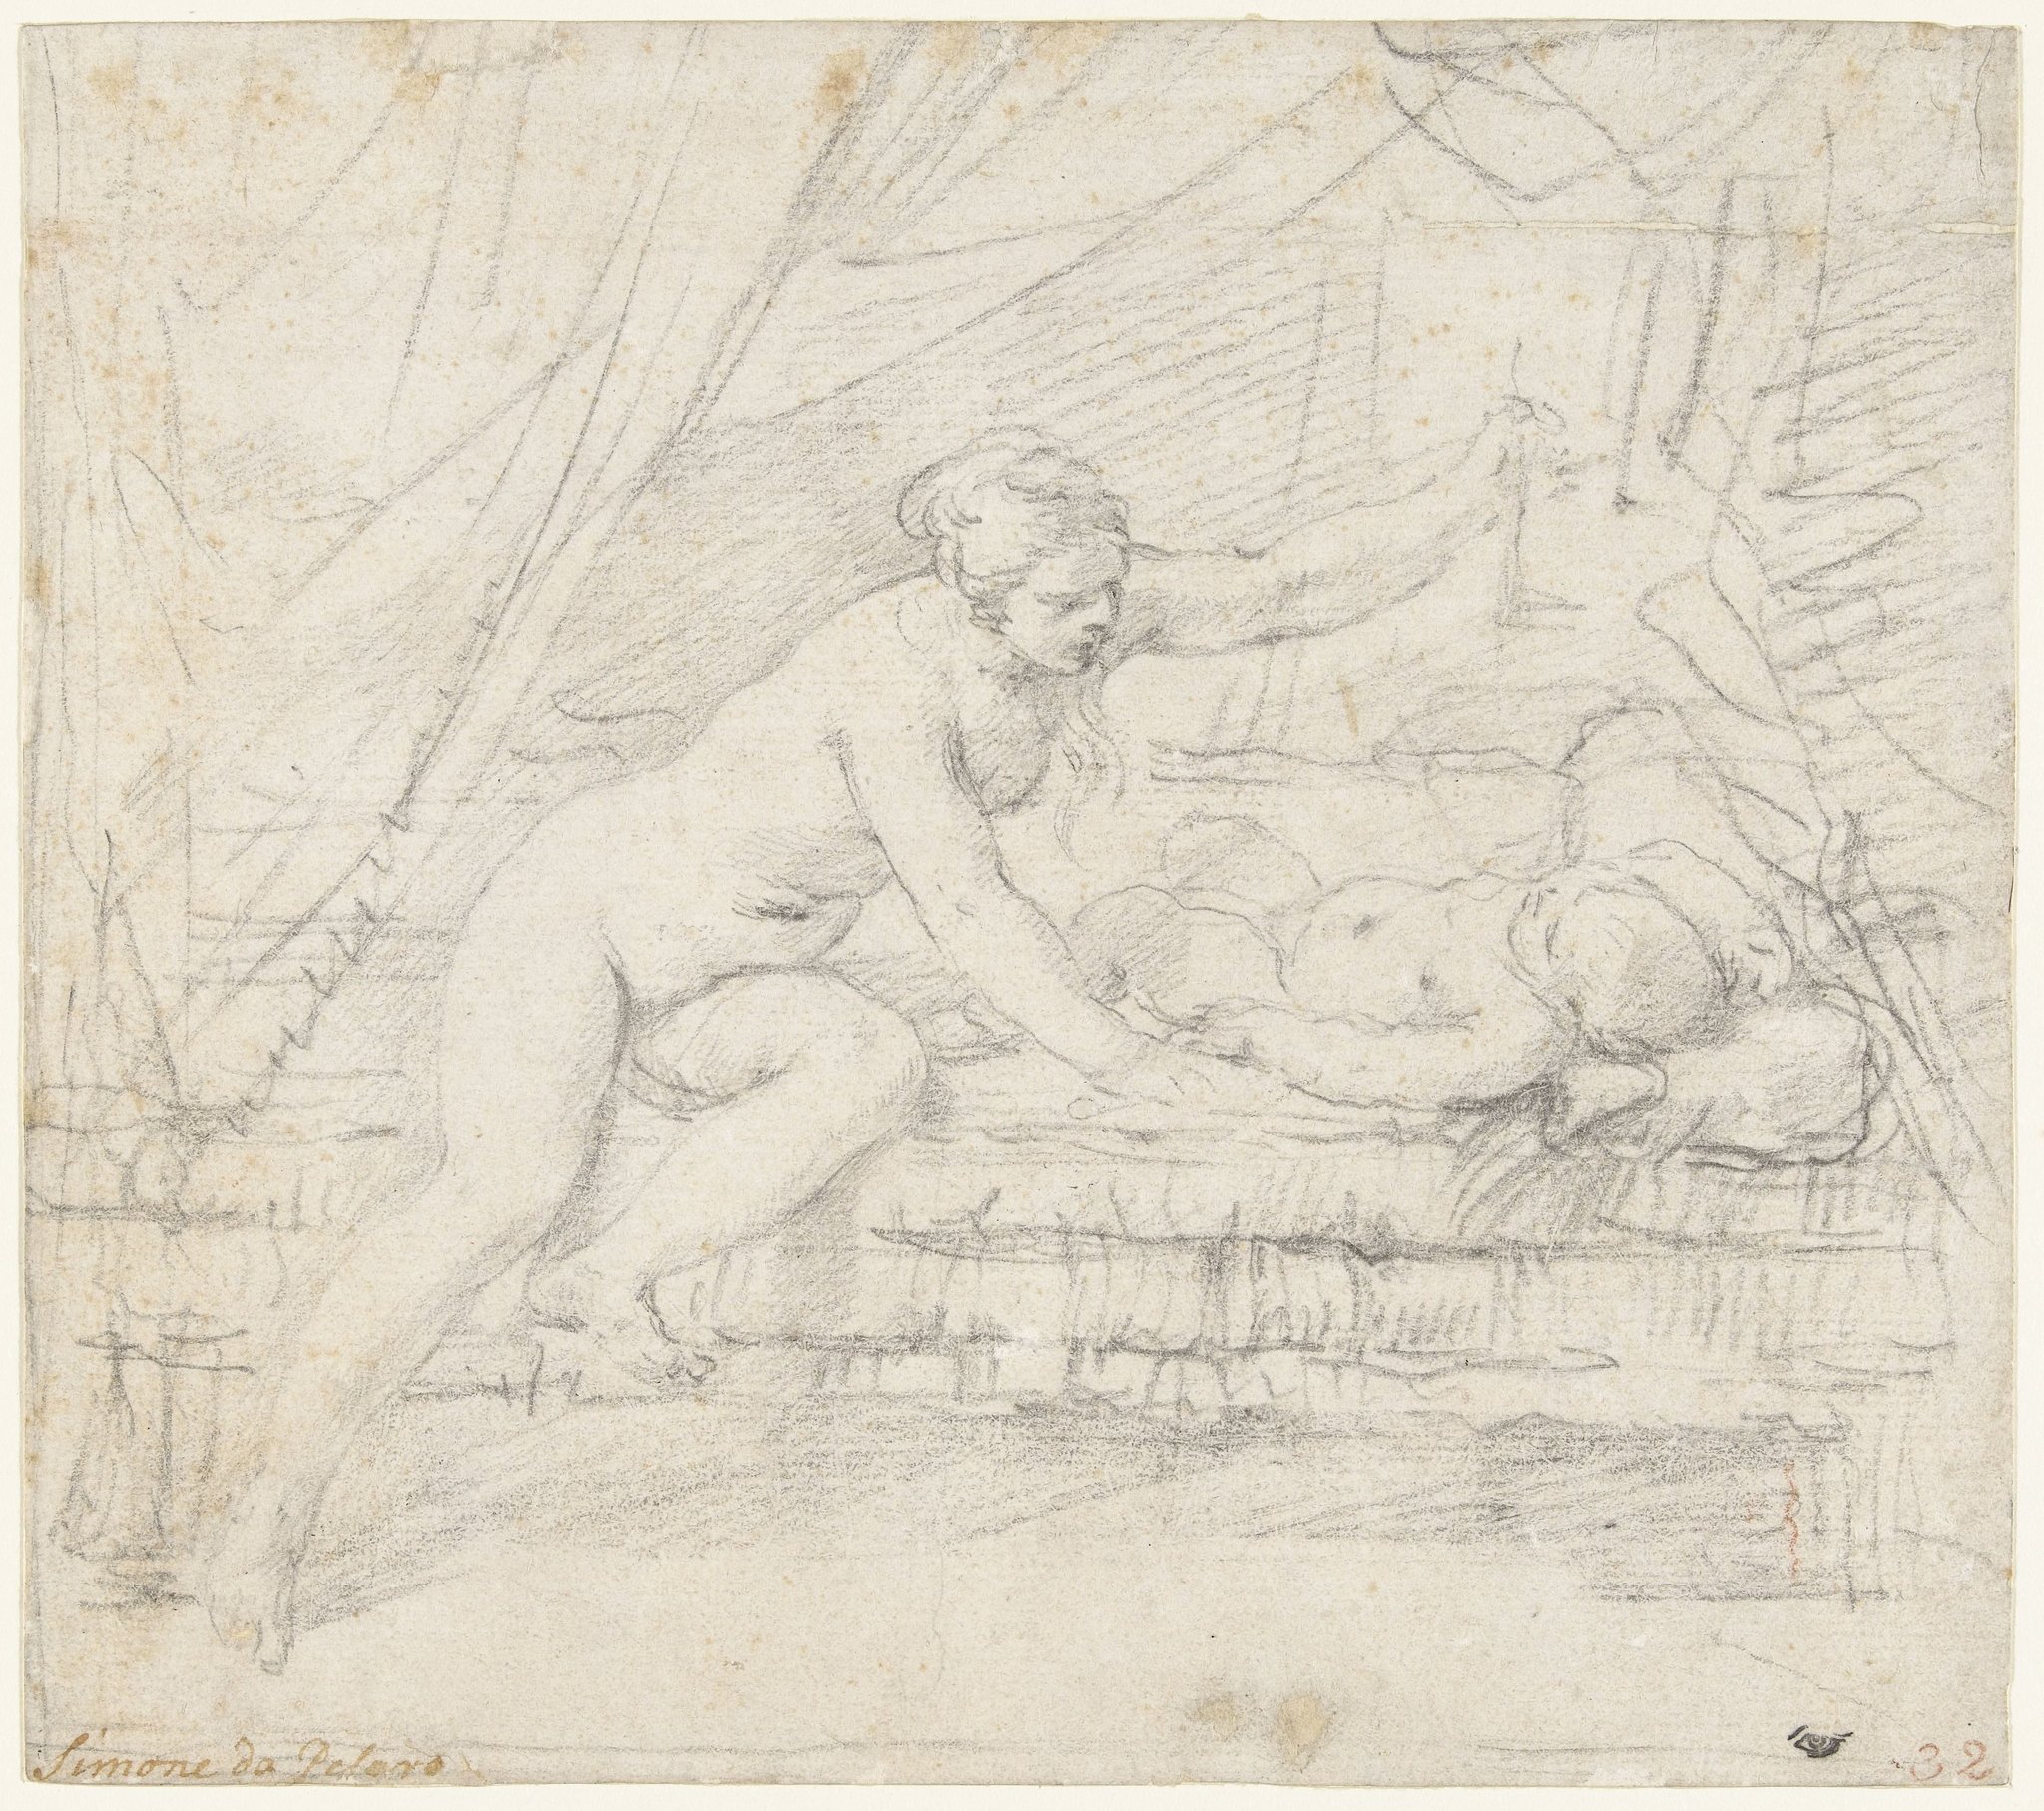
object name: drawing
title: Psyche verlicht met haar lamp de slapende Amor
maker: simone cantarini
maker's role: draughtsman, print maker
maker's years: 1612-1648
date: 1640-1645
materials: chalk, paper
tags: sleeping; unconsciousness